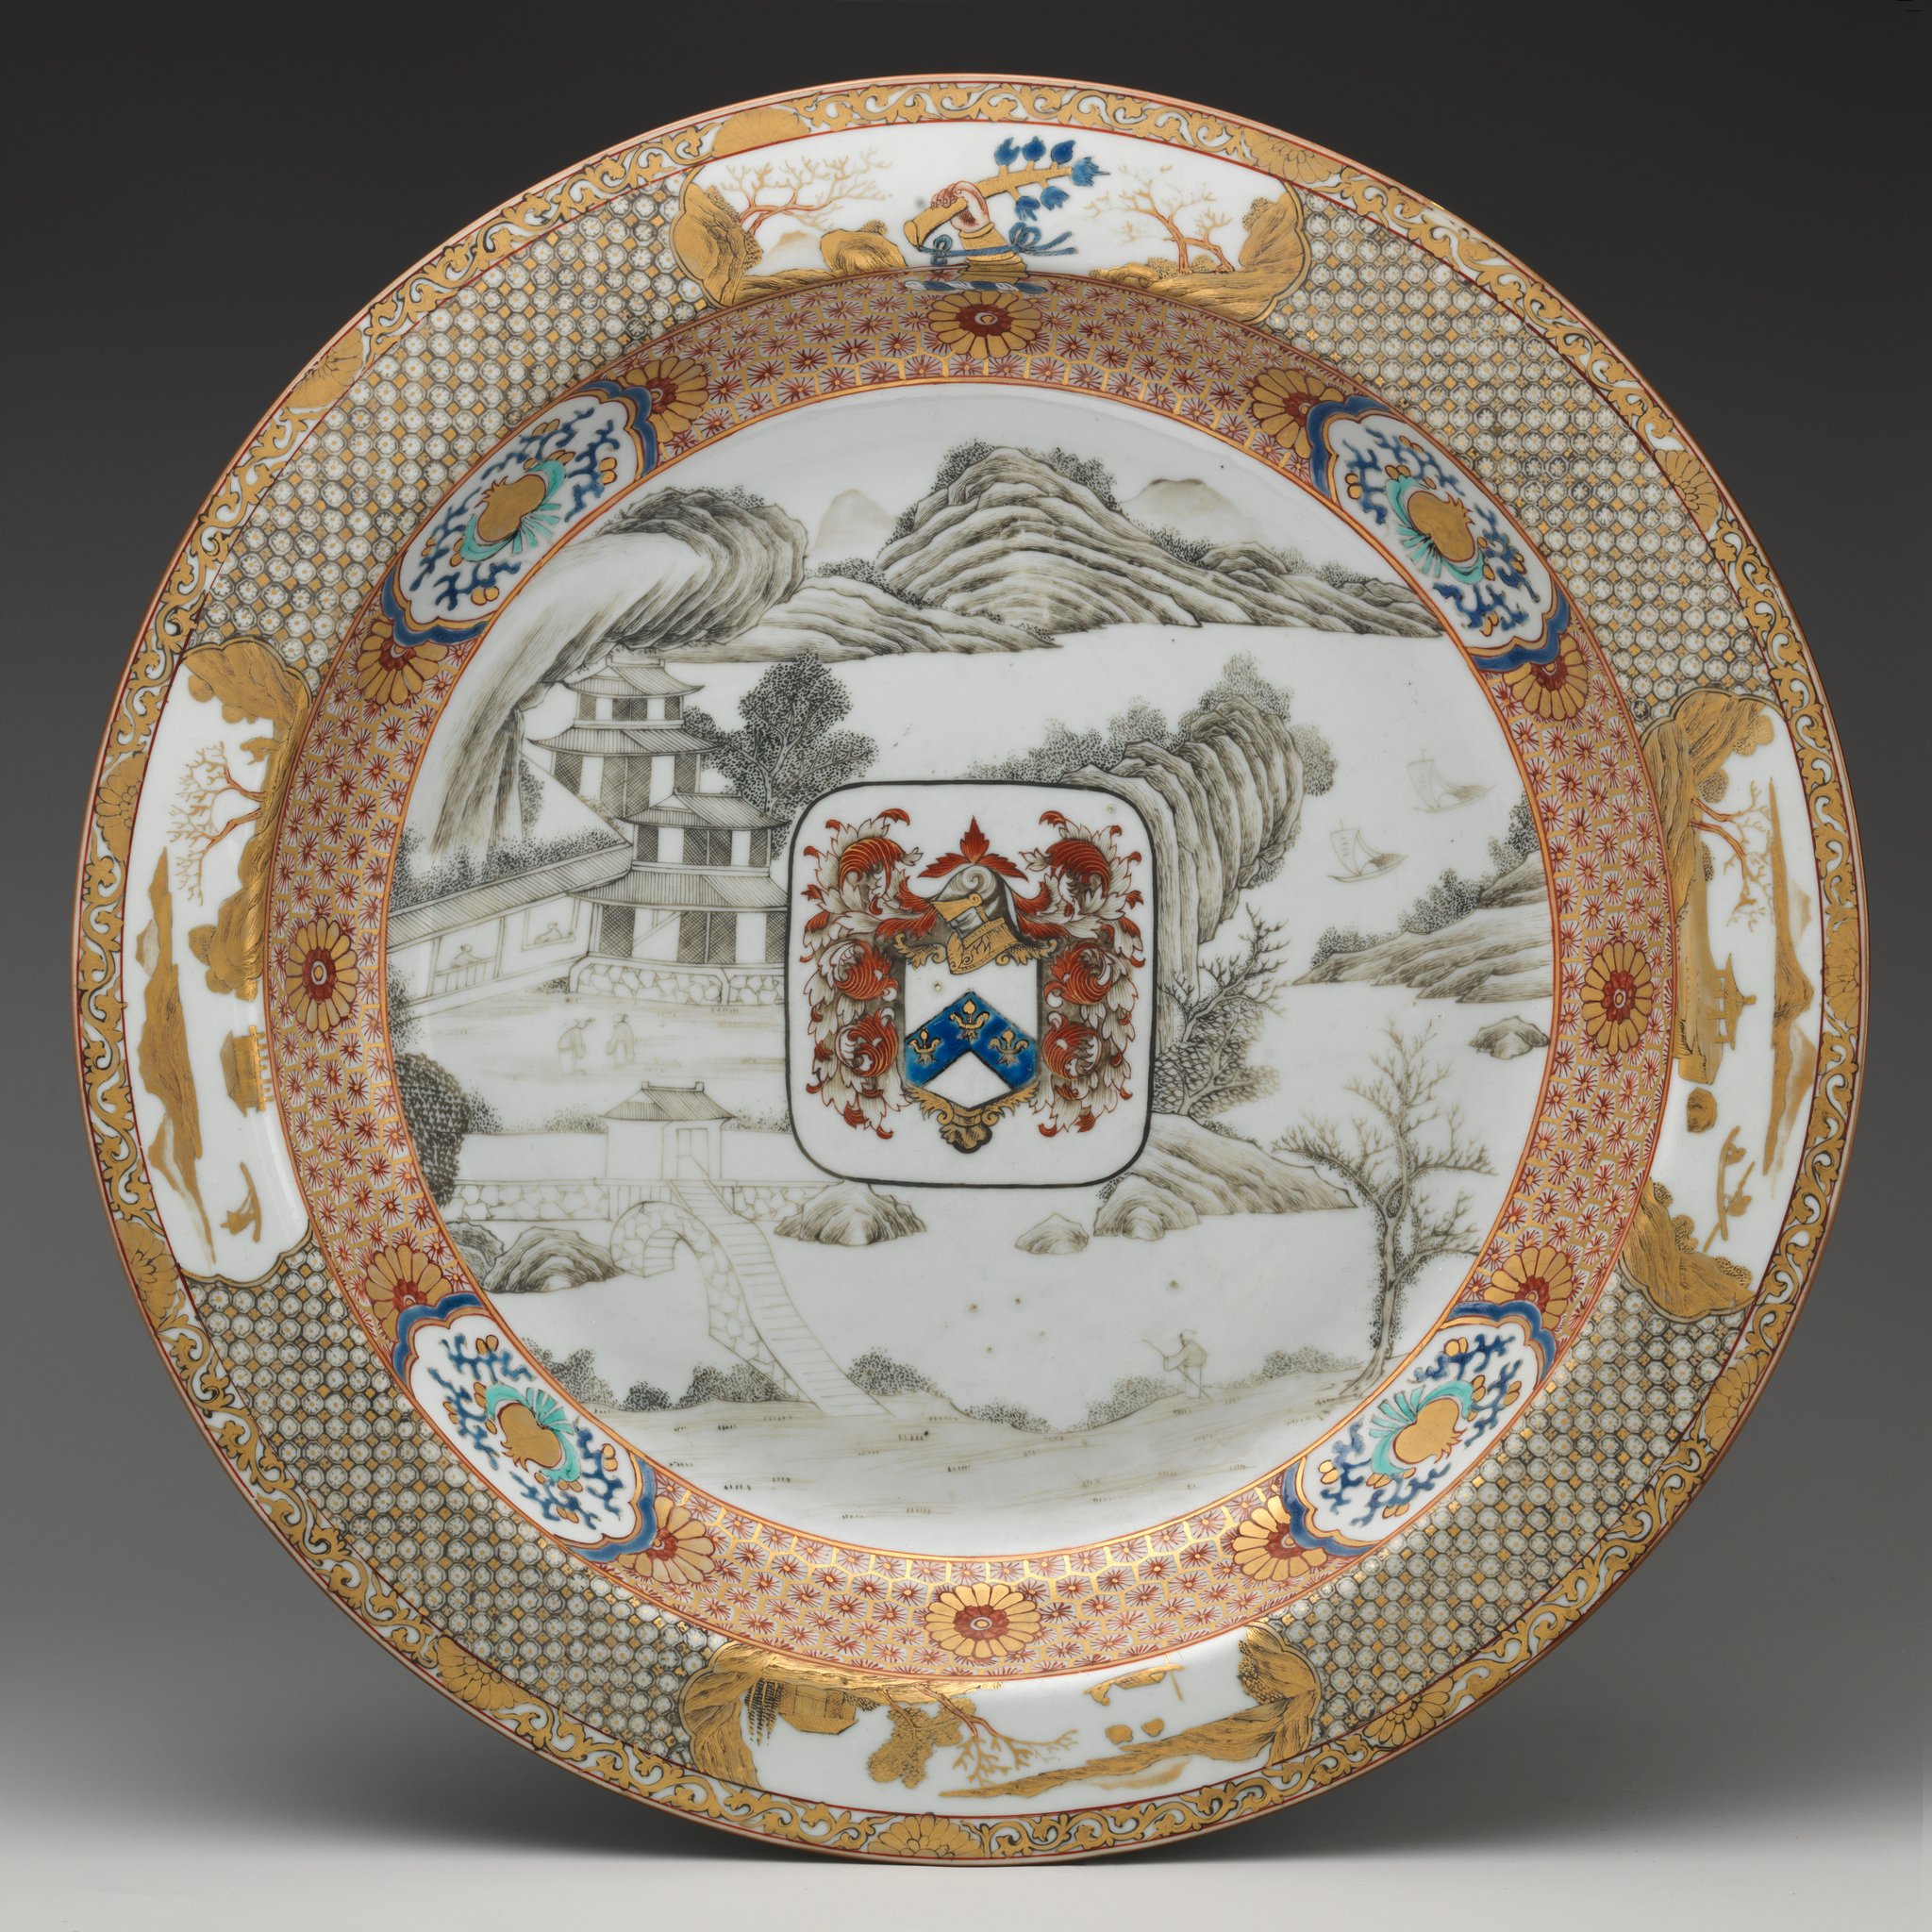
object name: plate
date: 1725-1730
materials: hard paste porcelain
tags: buildings,coat of arms